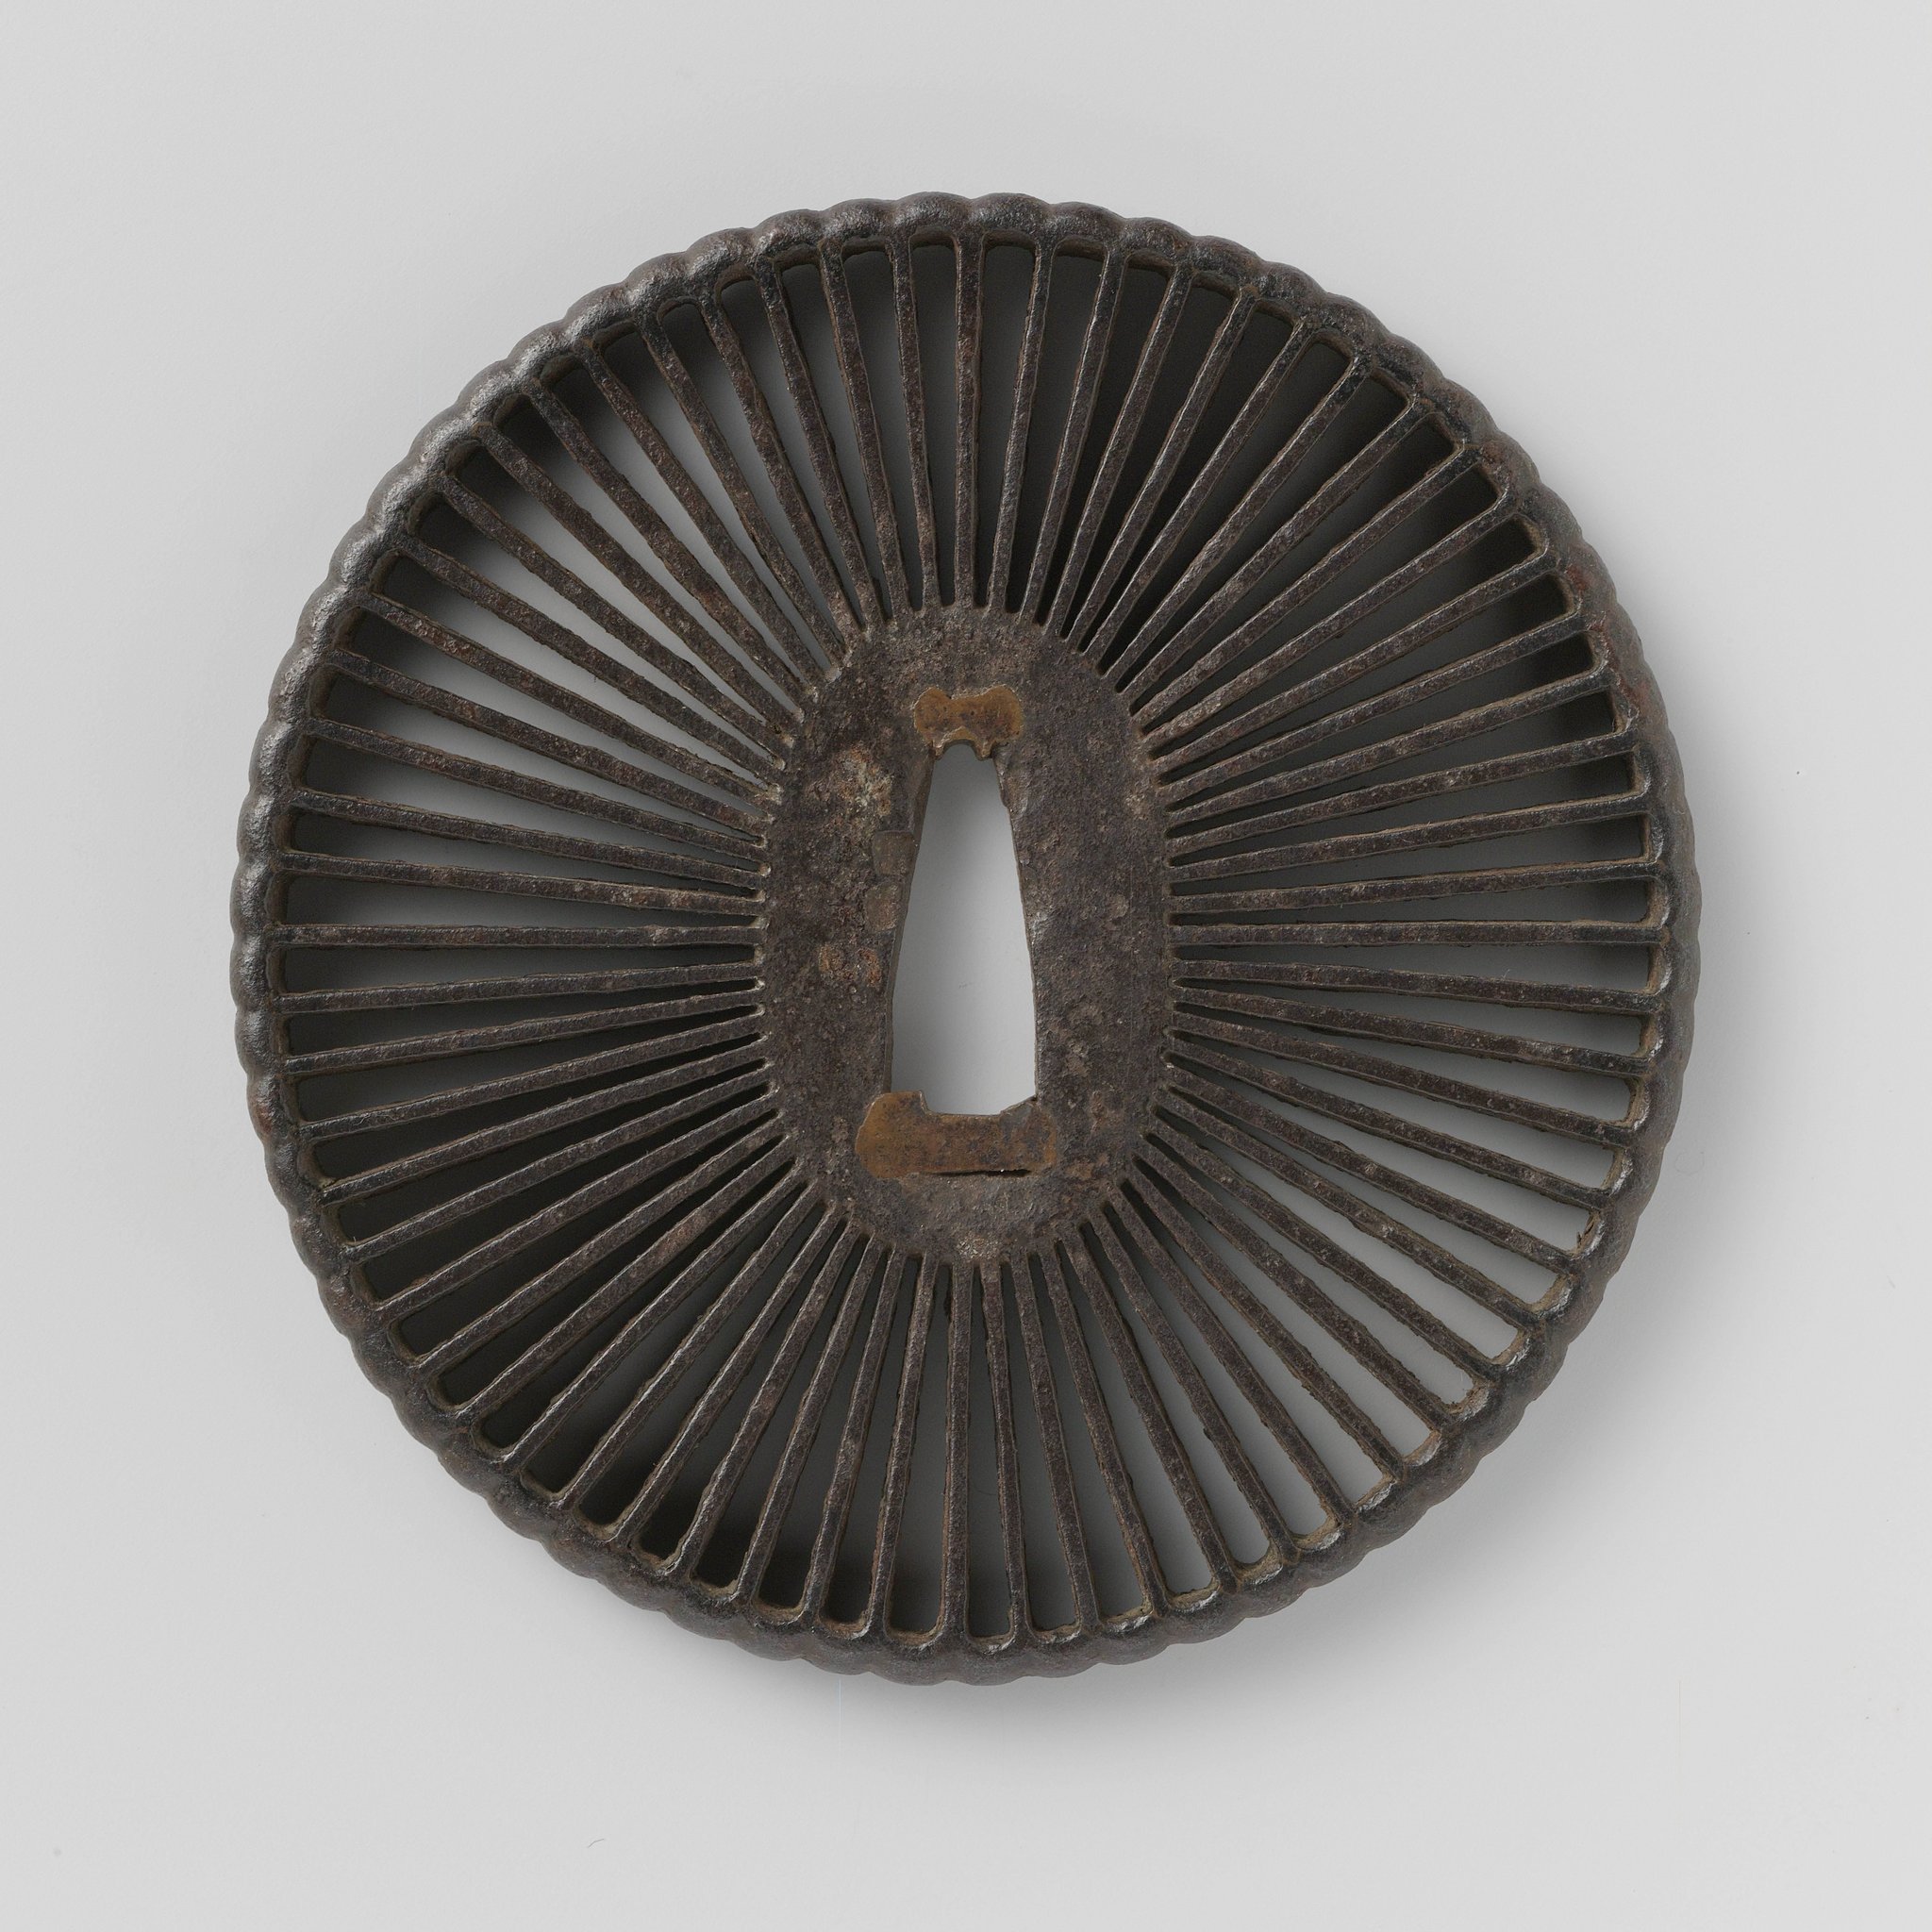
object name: tsuba, zwaardstootplaat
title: Hand guard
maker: Anonymous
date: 1600-1699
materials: iron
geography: japan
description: Ronde gelobde tsuba in de vorm van een gestileerde chrysant met 64 opengewerkte bladeren.